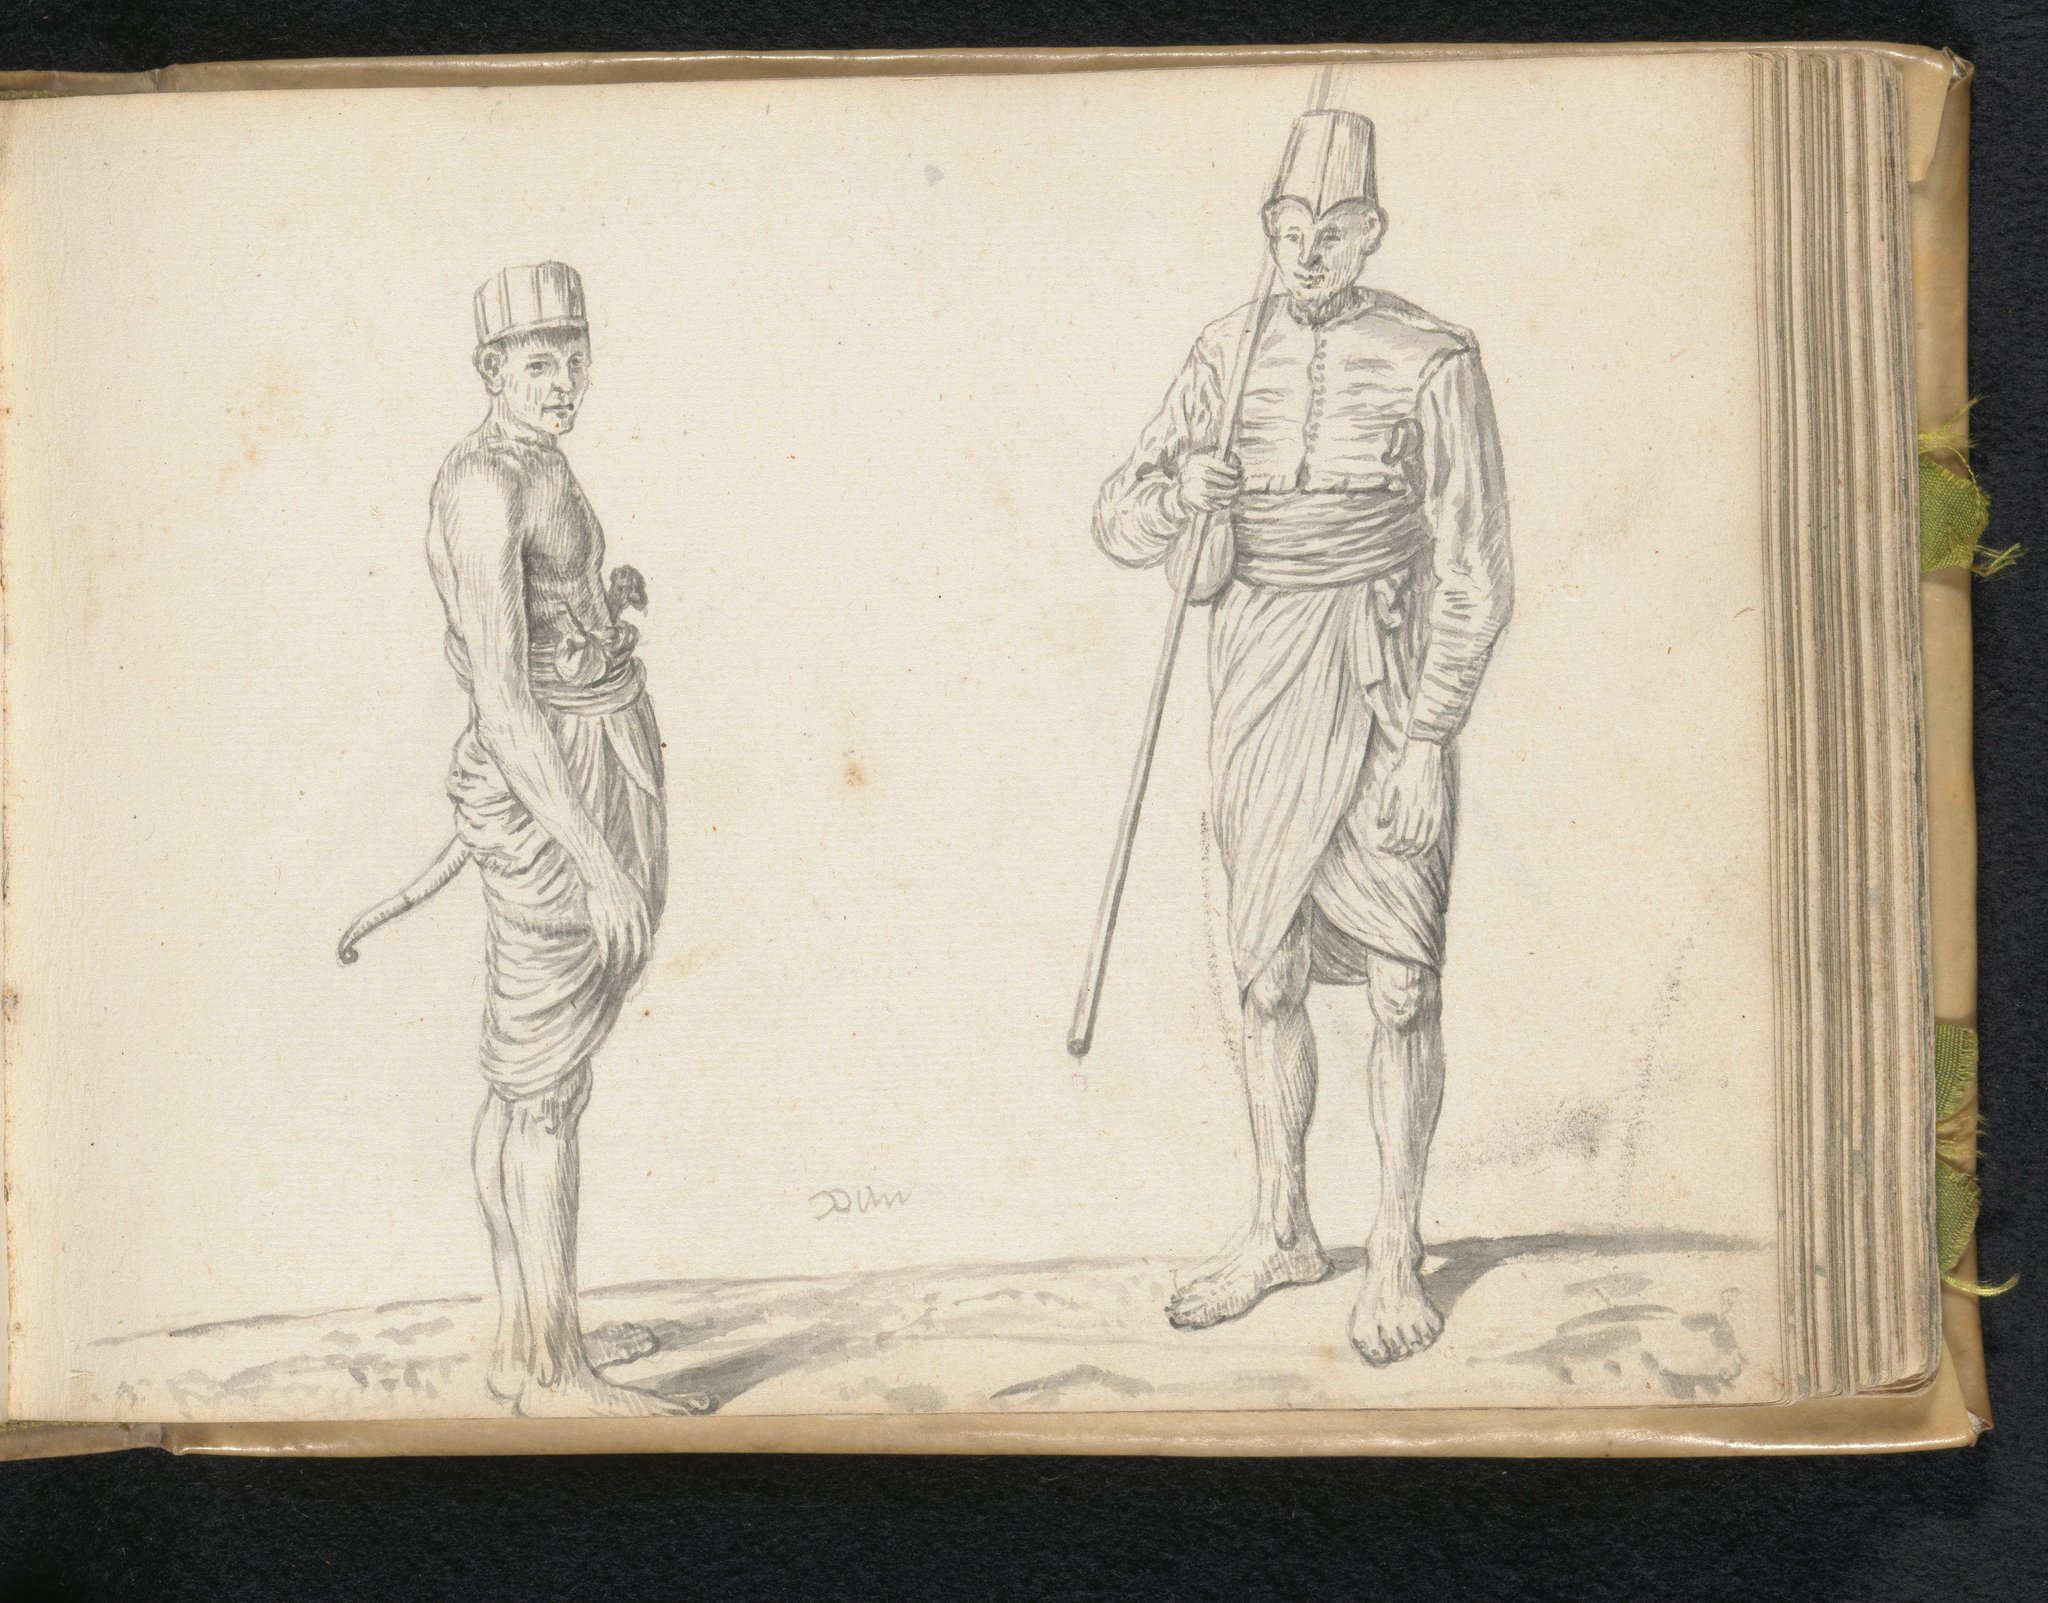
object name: sketchbook leaf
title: Two Sinhalese soldiers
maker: esaias boursse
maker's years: 1631-1672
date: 1662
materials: ink, paper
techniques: brush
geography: sri lanka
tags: asiatic races and peoples (with name), 41d232(...) skirt (lungi), hacing and thrusting weapons (with name), the soldier; the soldier's life, sri lanka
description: Twee mannen staan buiten op een oneffen terrein. De linker man is van rechts opzij getekend. Zijn bovenlijf is onbedekt. Hij draagt een op Singalese wijze omgewikkeld knielang heupkleed (veshti, lungi). Van de op zijn linkerheup gedragen halflang zwaard (kastane) zien we alleen het versierde gevest met leeuwenkopje en het gekrulde uiteinde van de schede. Hij draagt een ronde randloze muts. De man rechts is van voren getekend. Hij draagt een dichtgeknoopt kort jasje met lange mouwen en geplooide onderrand (hettaya), daaronder een op Singalese wijze omgewikkeld knielang heupkleed (veshti, lungi) en om het middel een hoge tailleband. In zijn rechterhand draagt hij iets wat lijkt op een zakje, en een lange stok die tegen zijn rechterschouder leunt, is waarschijnlijk een lans of een speer. Onder zijn linkerarm steekt het versierde gevest uit van een kort zwaard (kastane). Op zijn hoofd een typische muts (of helm?): hoog, stijf, met een punt aan de voorkant. Beide mannen zijn Singalese huursoldaten (lascorijnen), nu in dienst van de Nederlanders. Ze horen tot de kaste der Goviya. Blad 23 uit een schetsboek met 117 bladen.